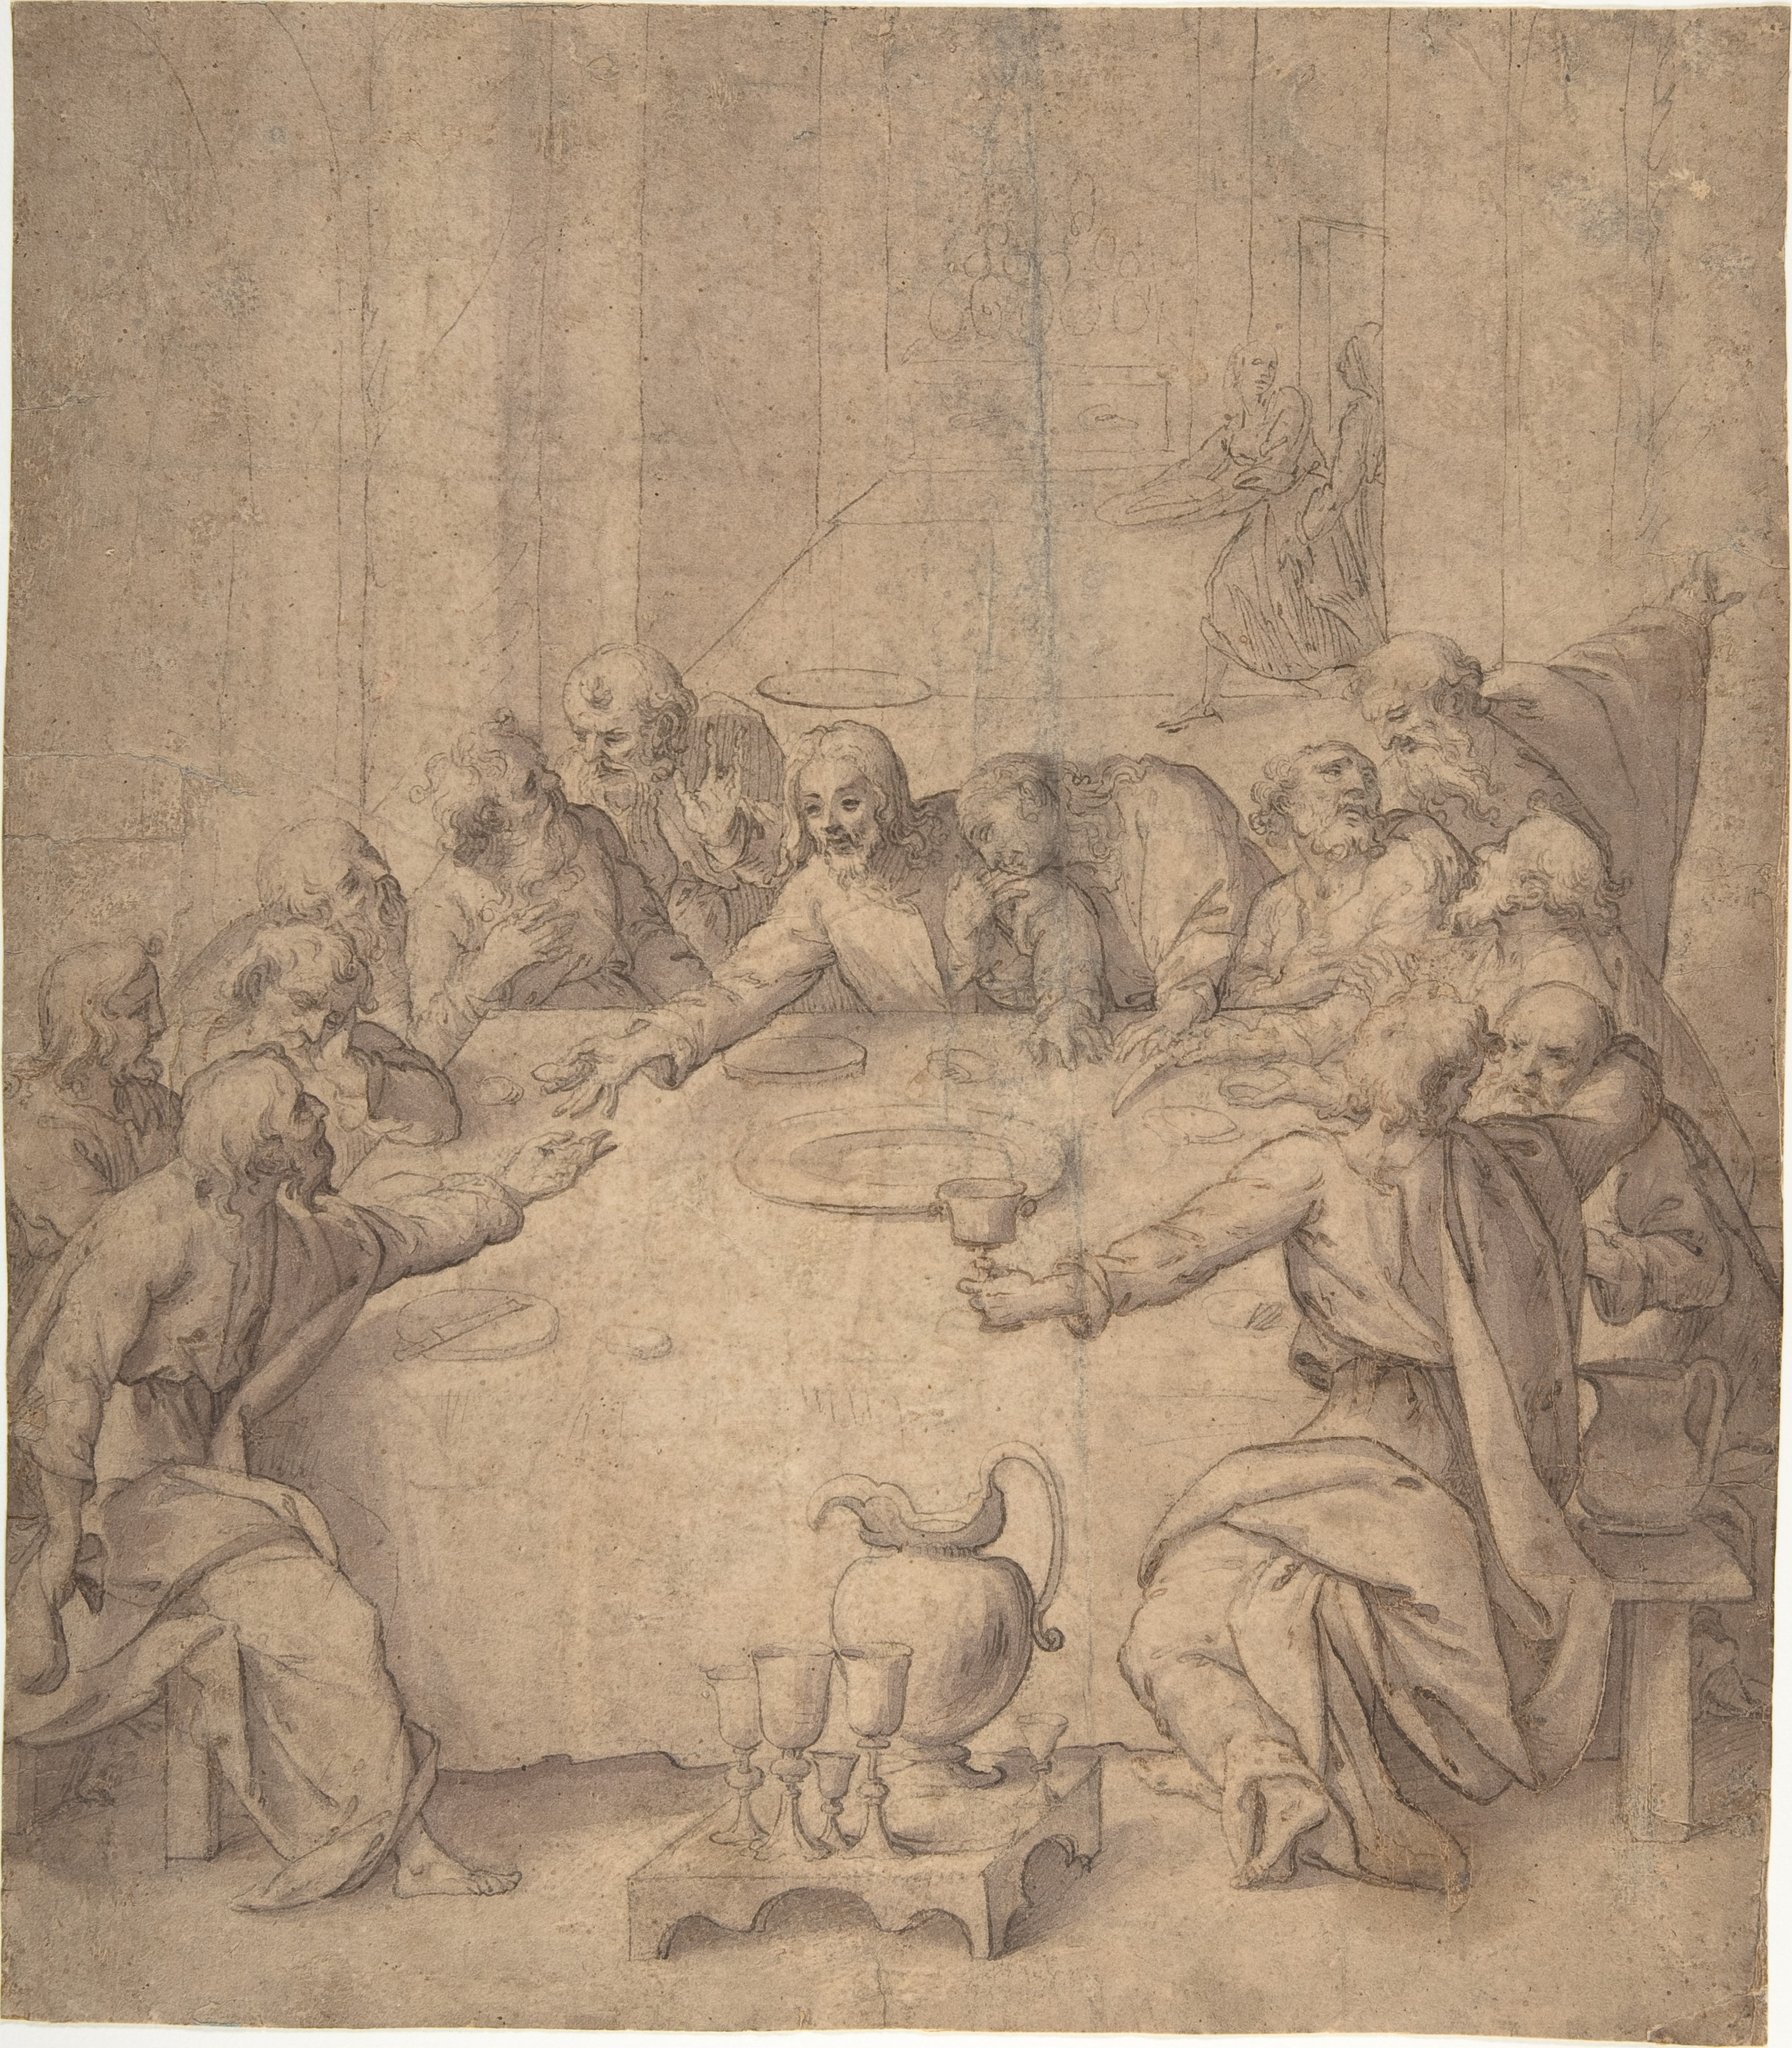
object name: drawing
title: The Last Supper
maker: francesco curia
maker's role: artist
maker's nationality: italian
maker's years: 1565-1608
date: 1565-1608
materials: ink, paper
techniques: brush, pen, wash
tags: last supper